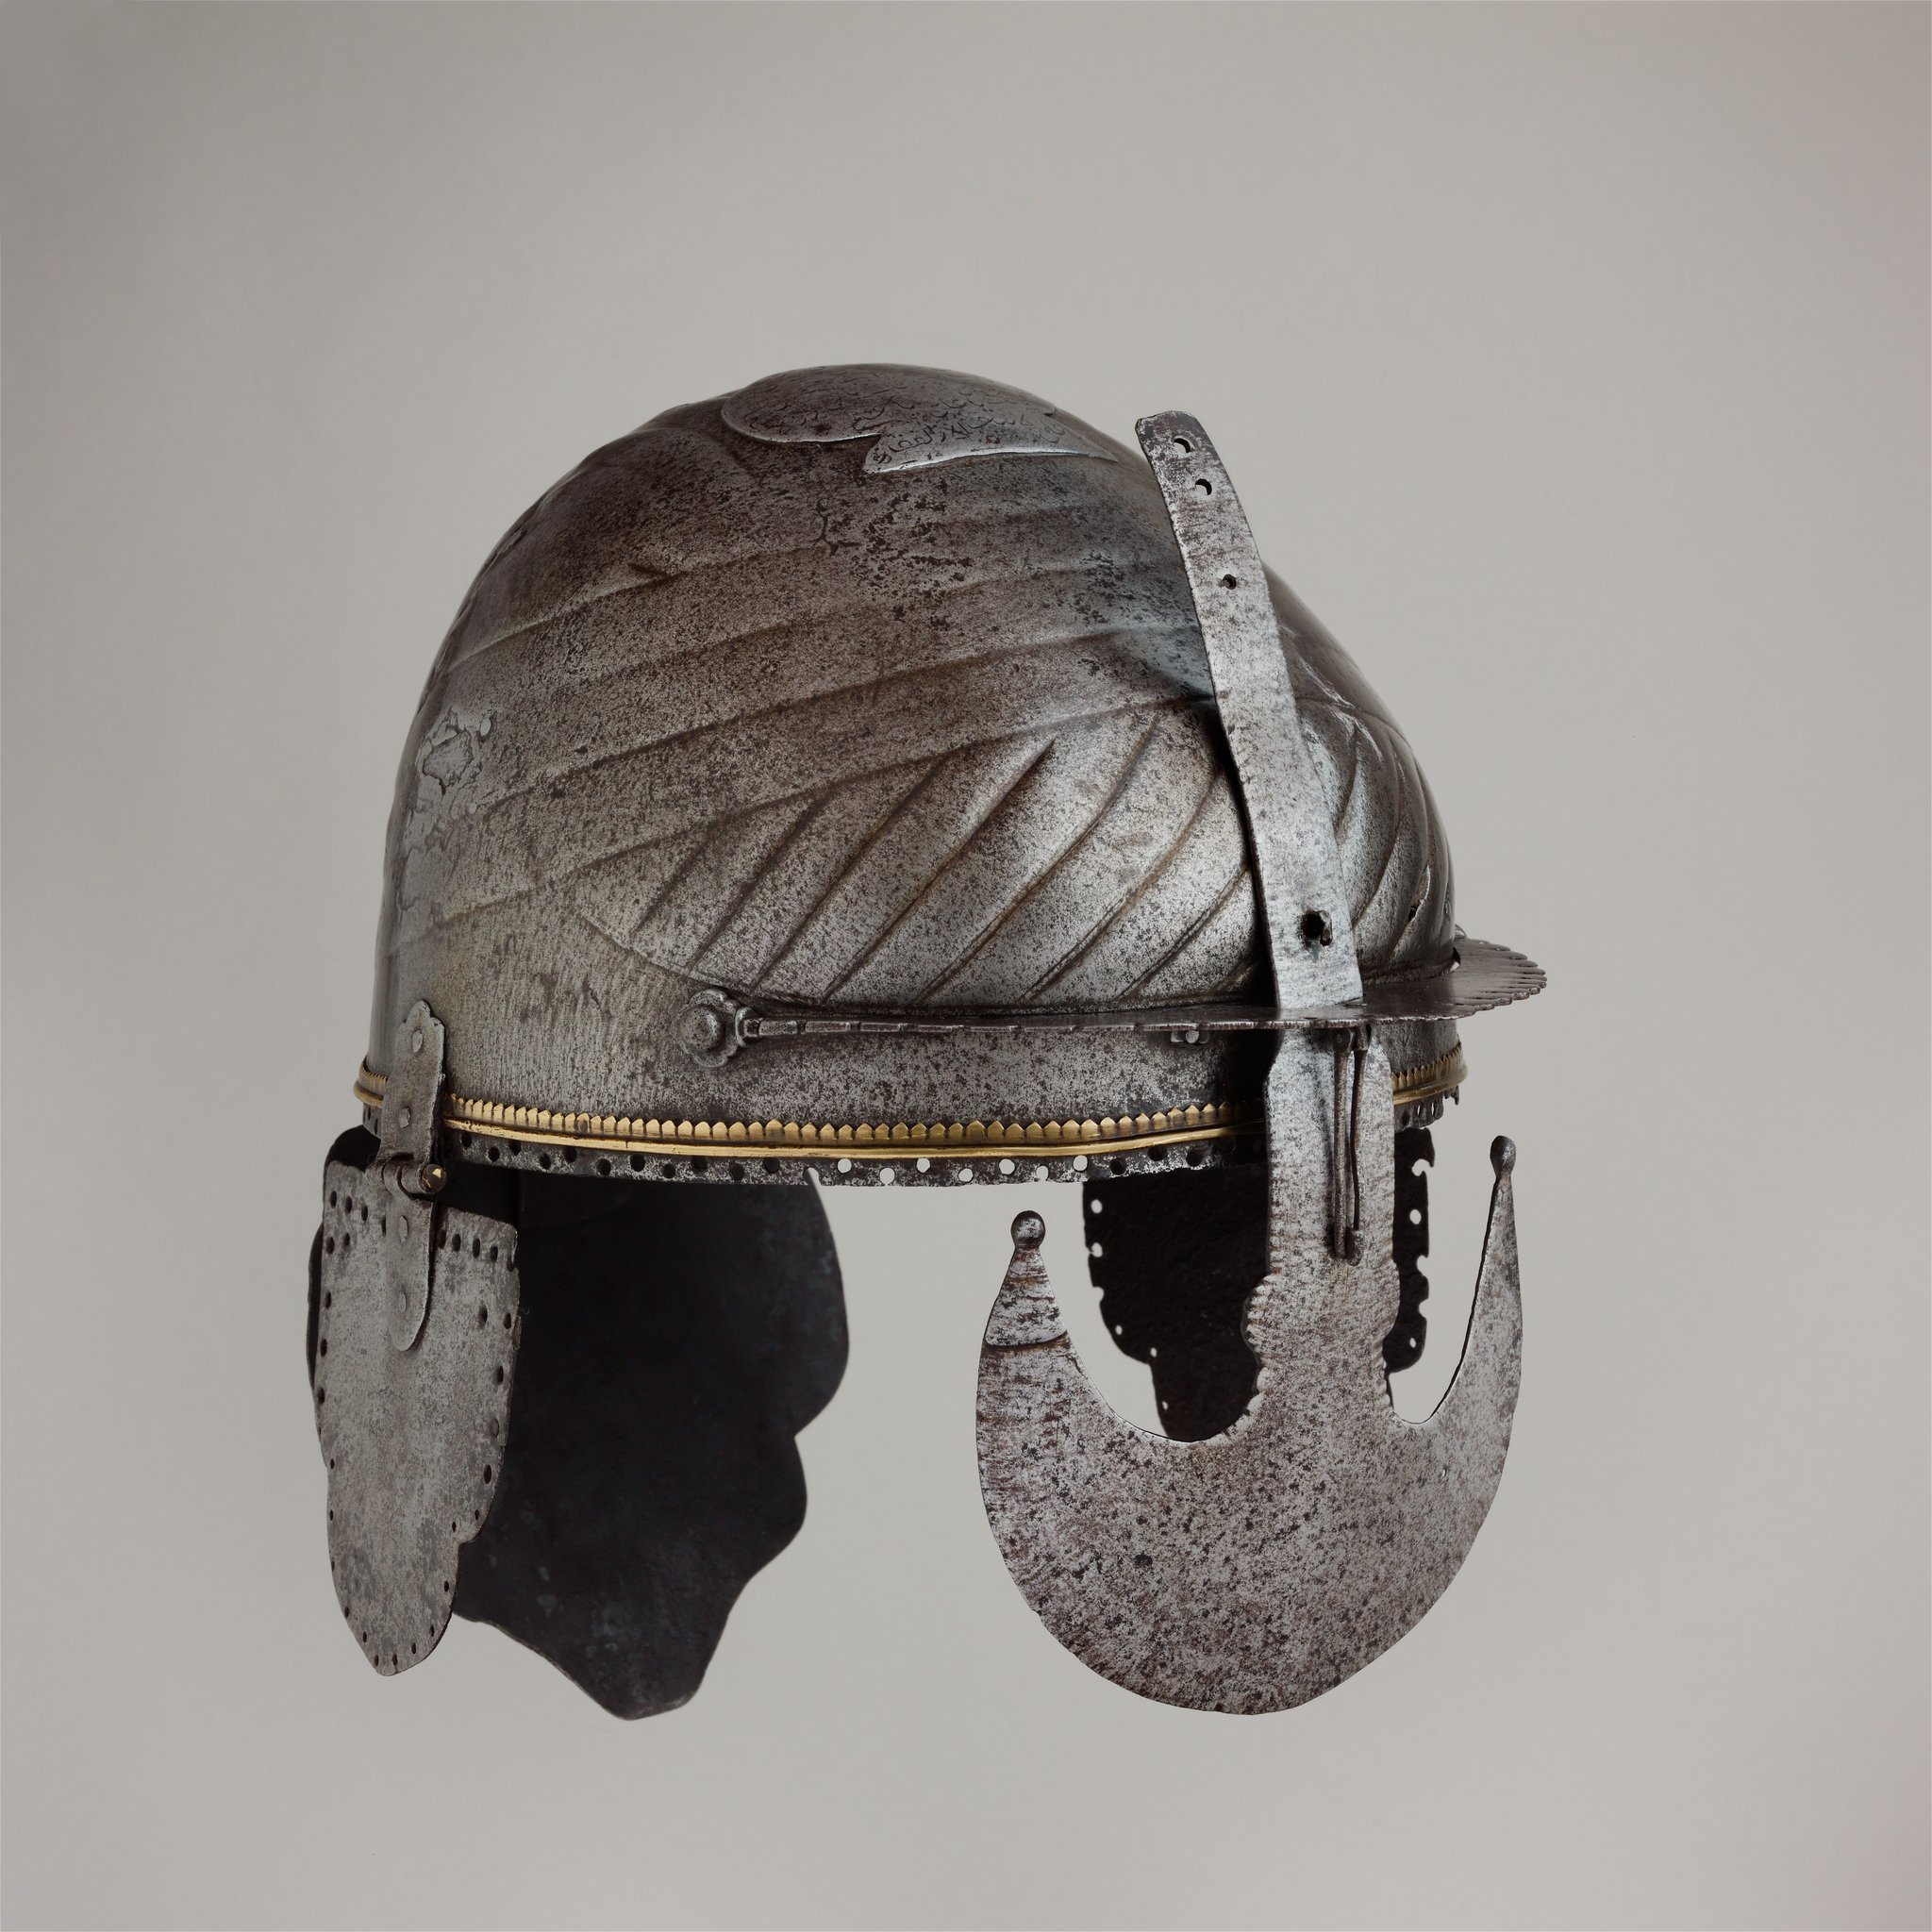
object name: helmet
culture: indian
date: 1601-1700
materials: copper alloy, iron, steel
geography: india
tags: arabic